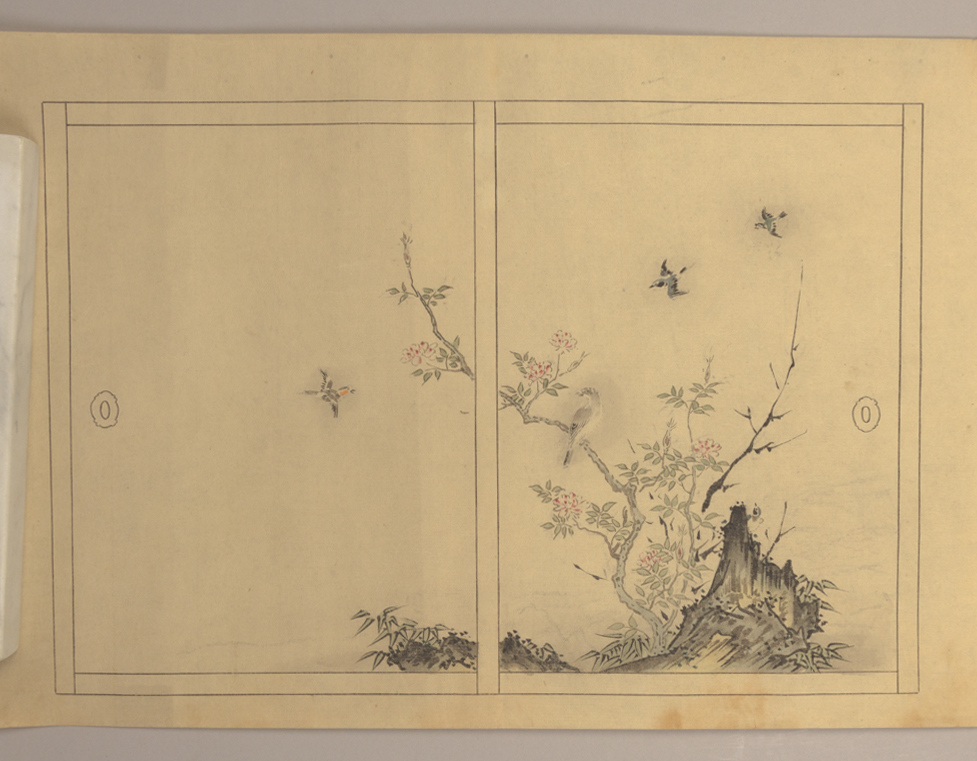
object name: drawing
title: Japanese Drawing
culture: japanese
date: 1801-1833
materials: paper